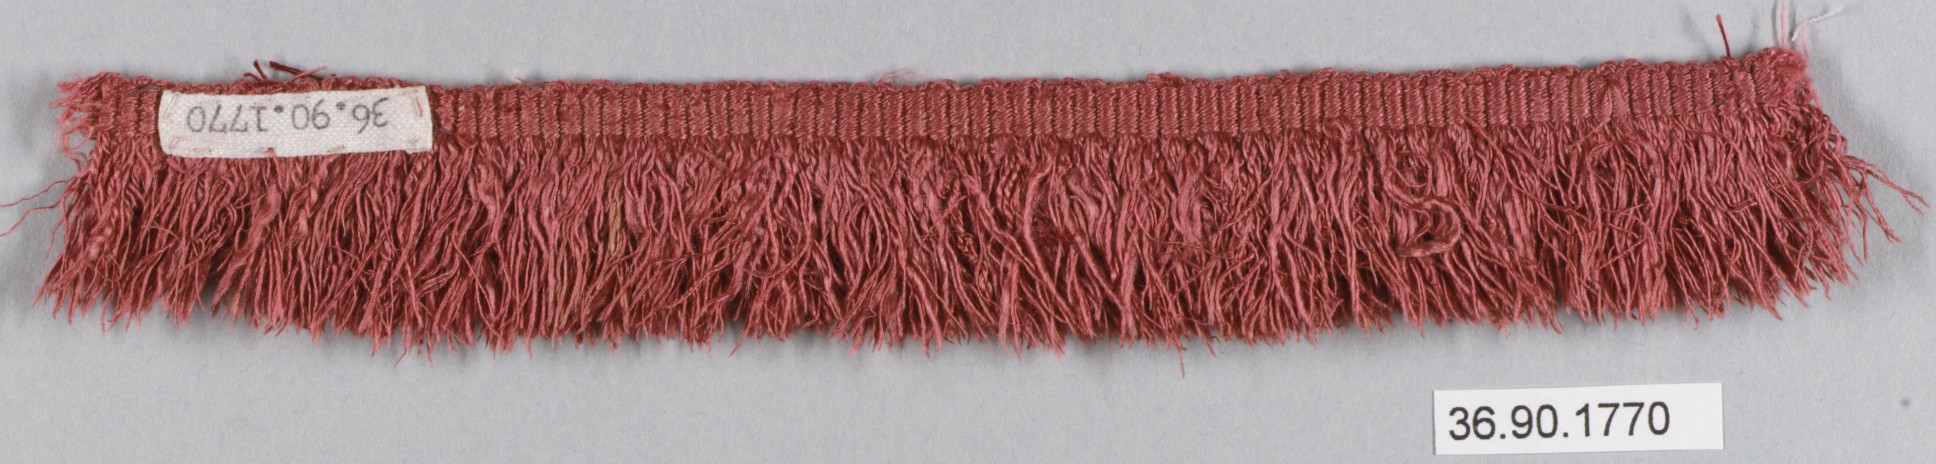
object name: fringe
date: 1750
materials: silk